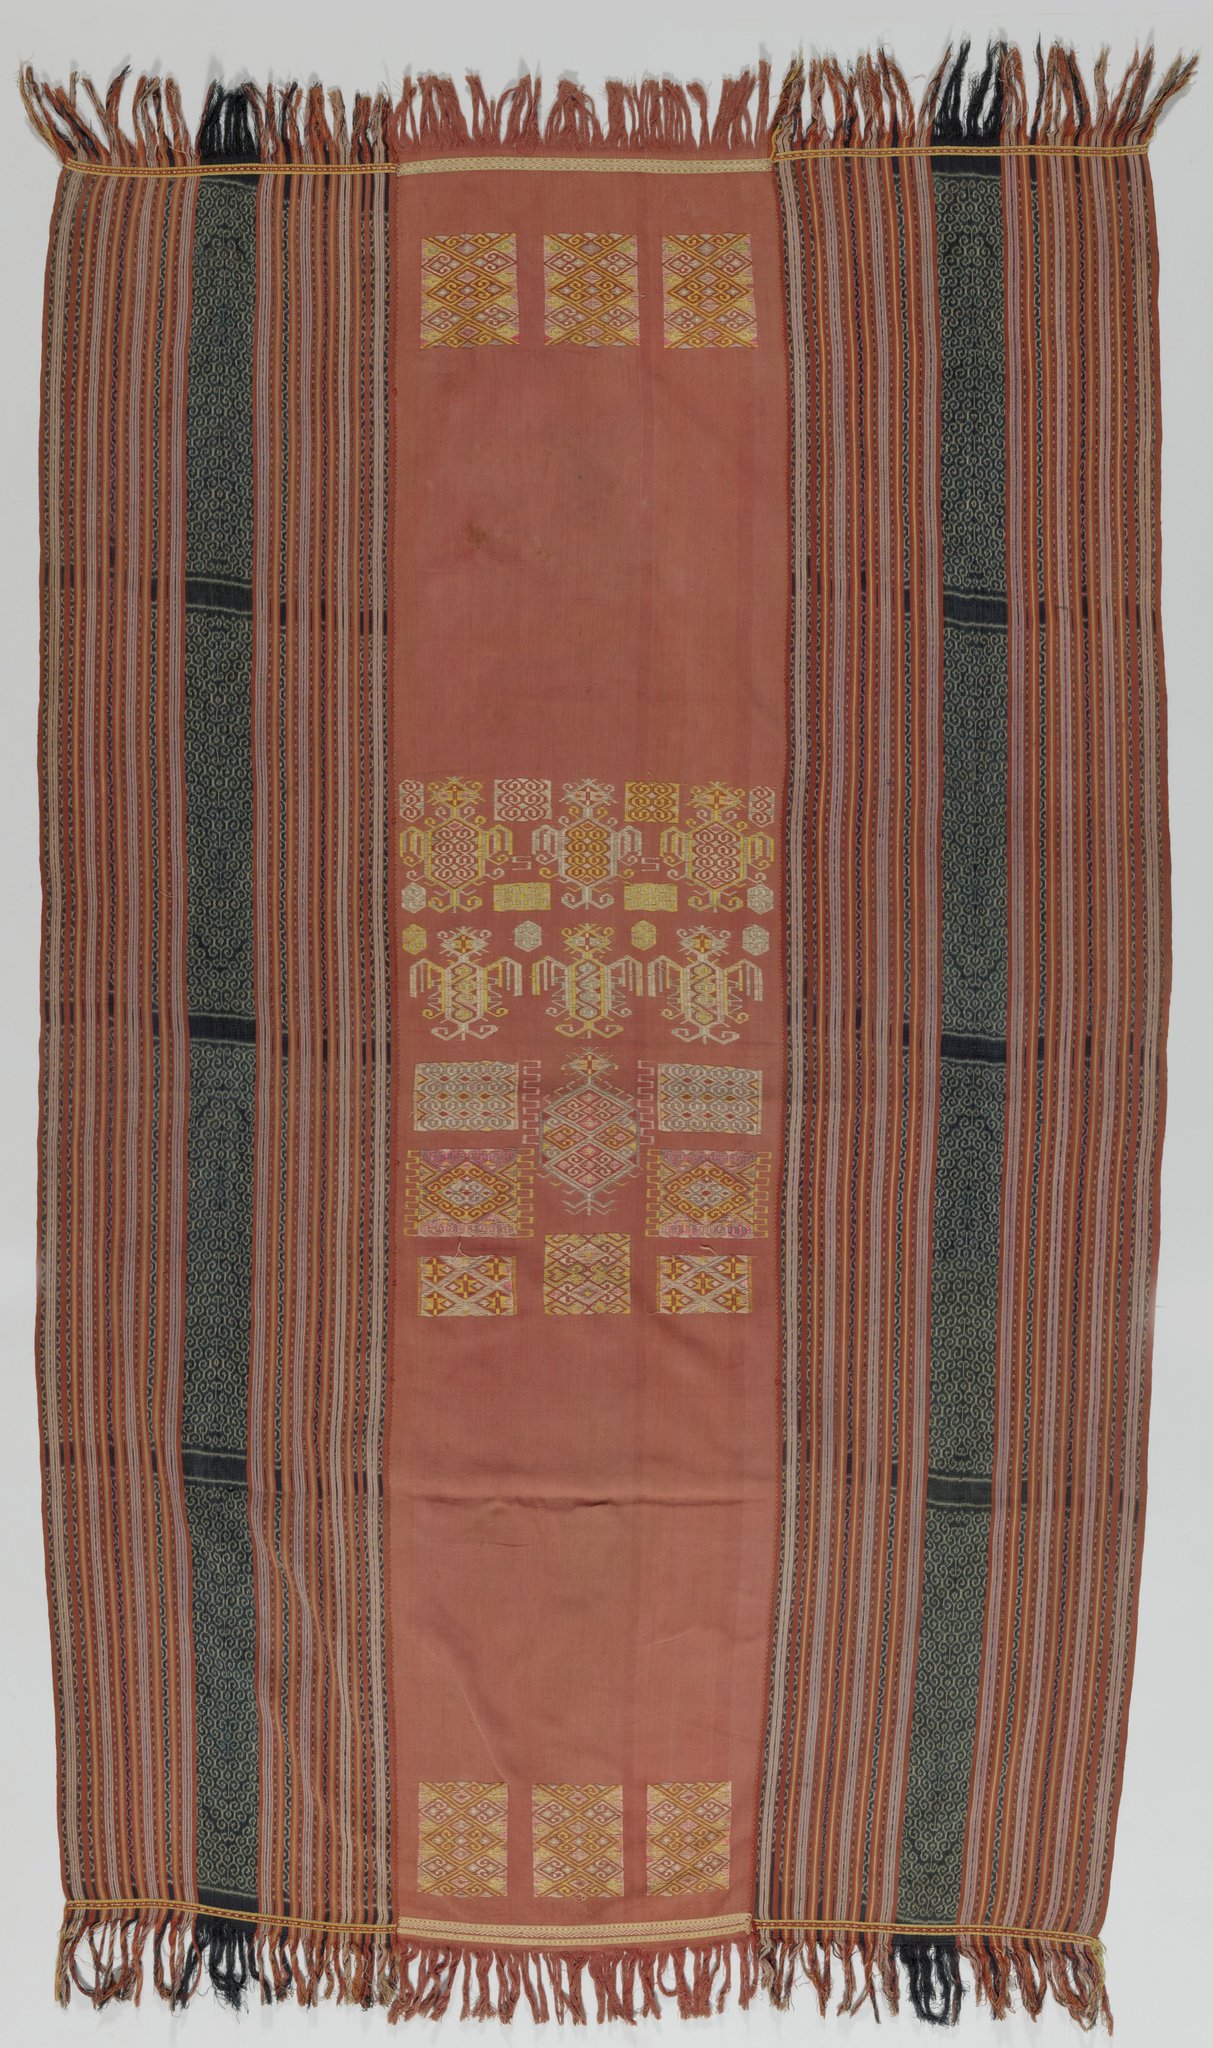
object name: omslagdoek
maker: Anonymous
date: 1900-1949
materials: cotton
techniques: ikat, weave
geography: timor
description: Omslagdoek met geometrische, vogel- en haakmotieven.